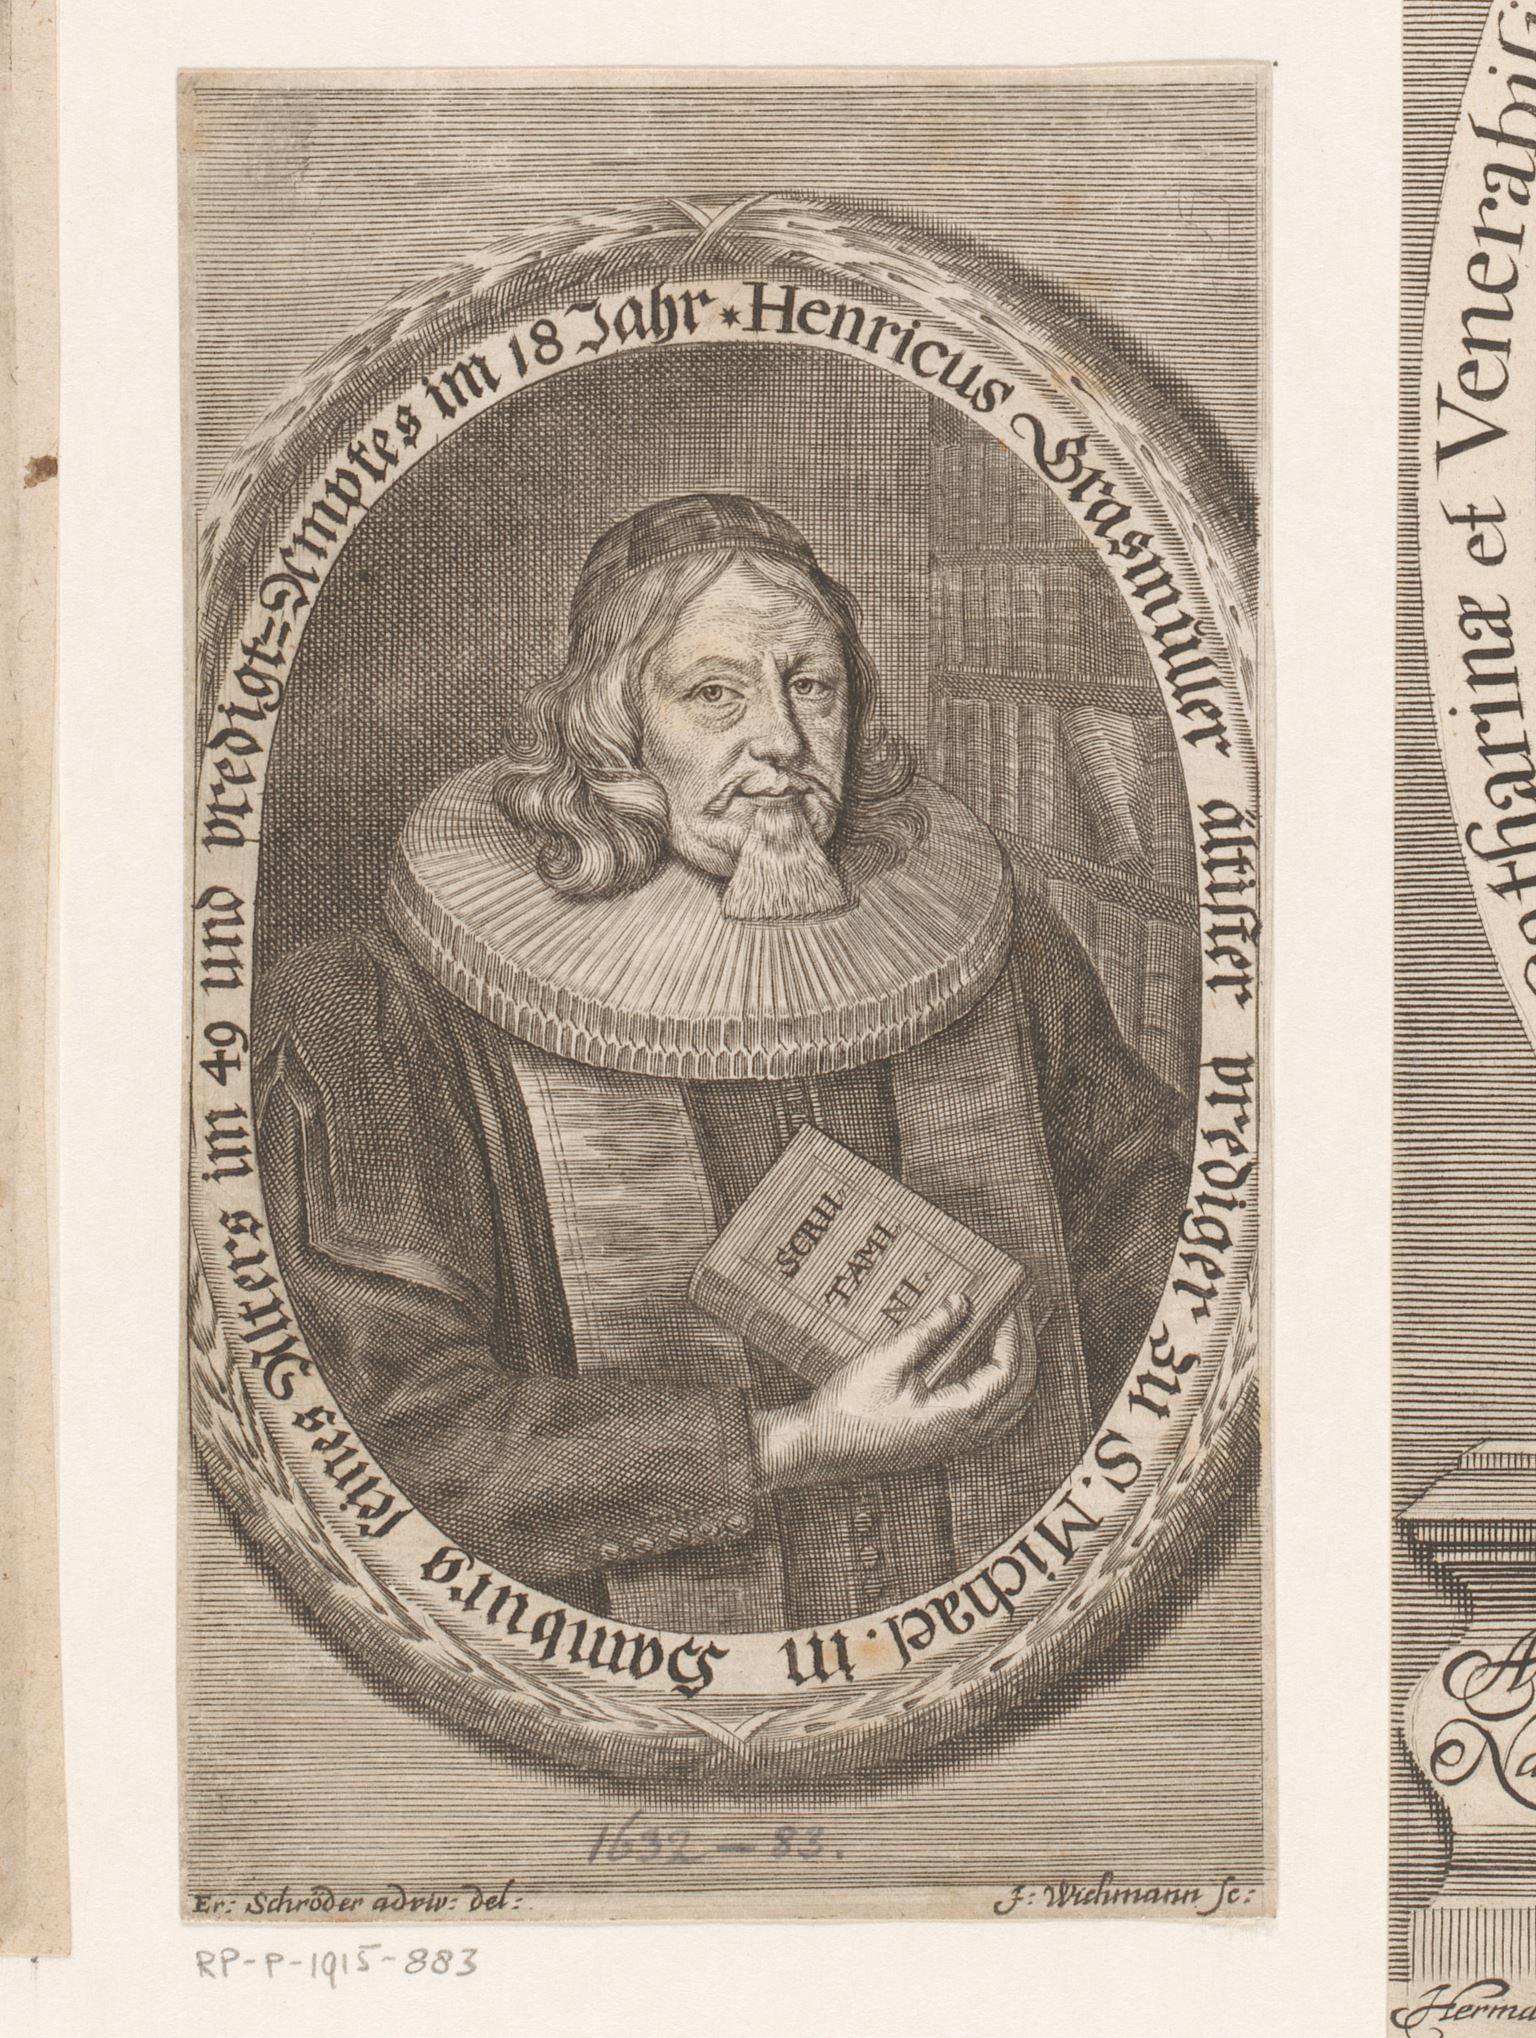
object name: print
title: Portret van Heinrich Grasmüller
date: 1670-1686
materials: paper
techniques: engraving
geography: germany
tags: historical persons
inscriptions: collector's mark: Lugt 2228